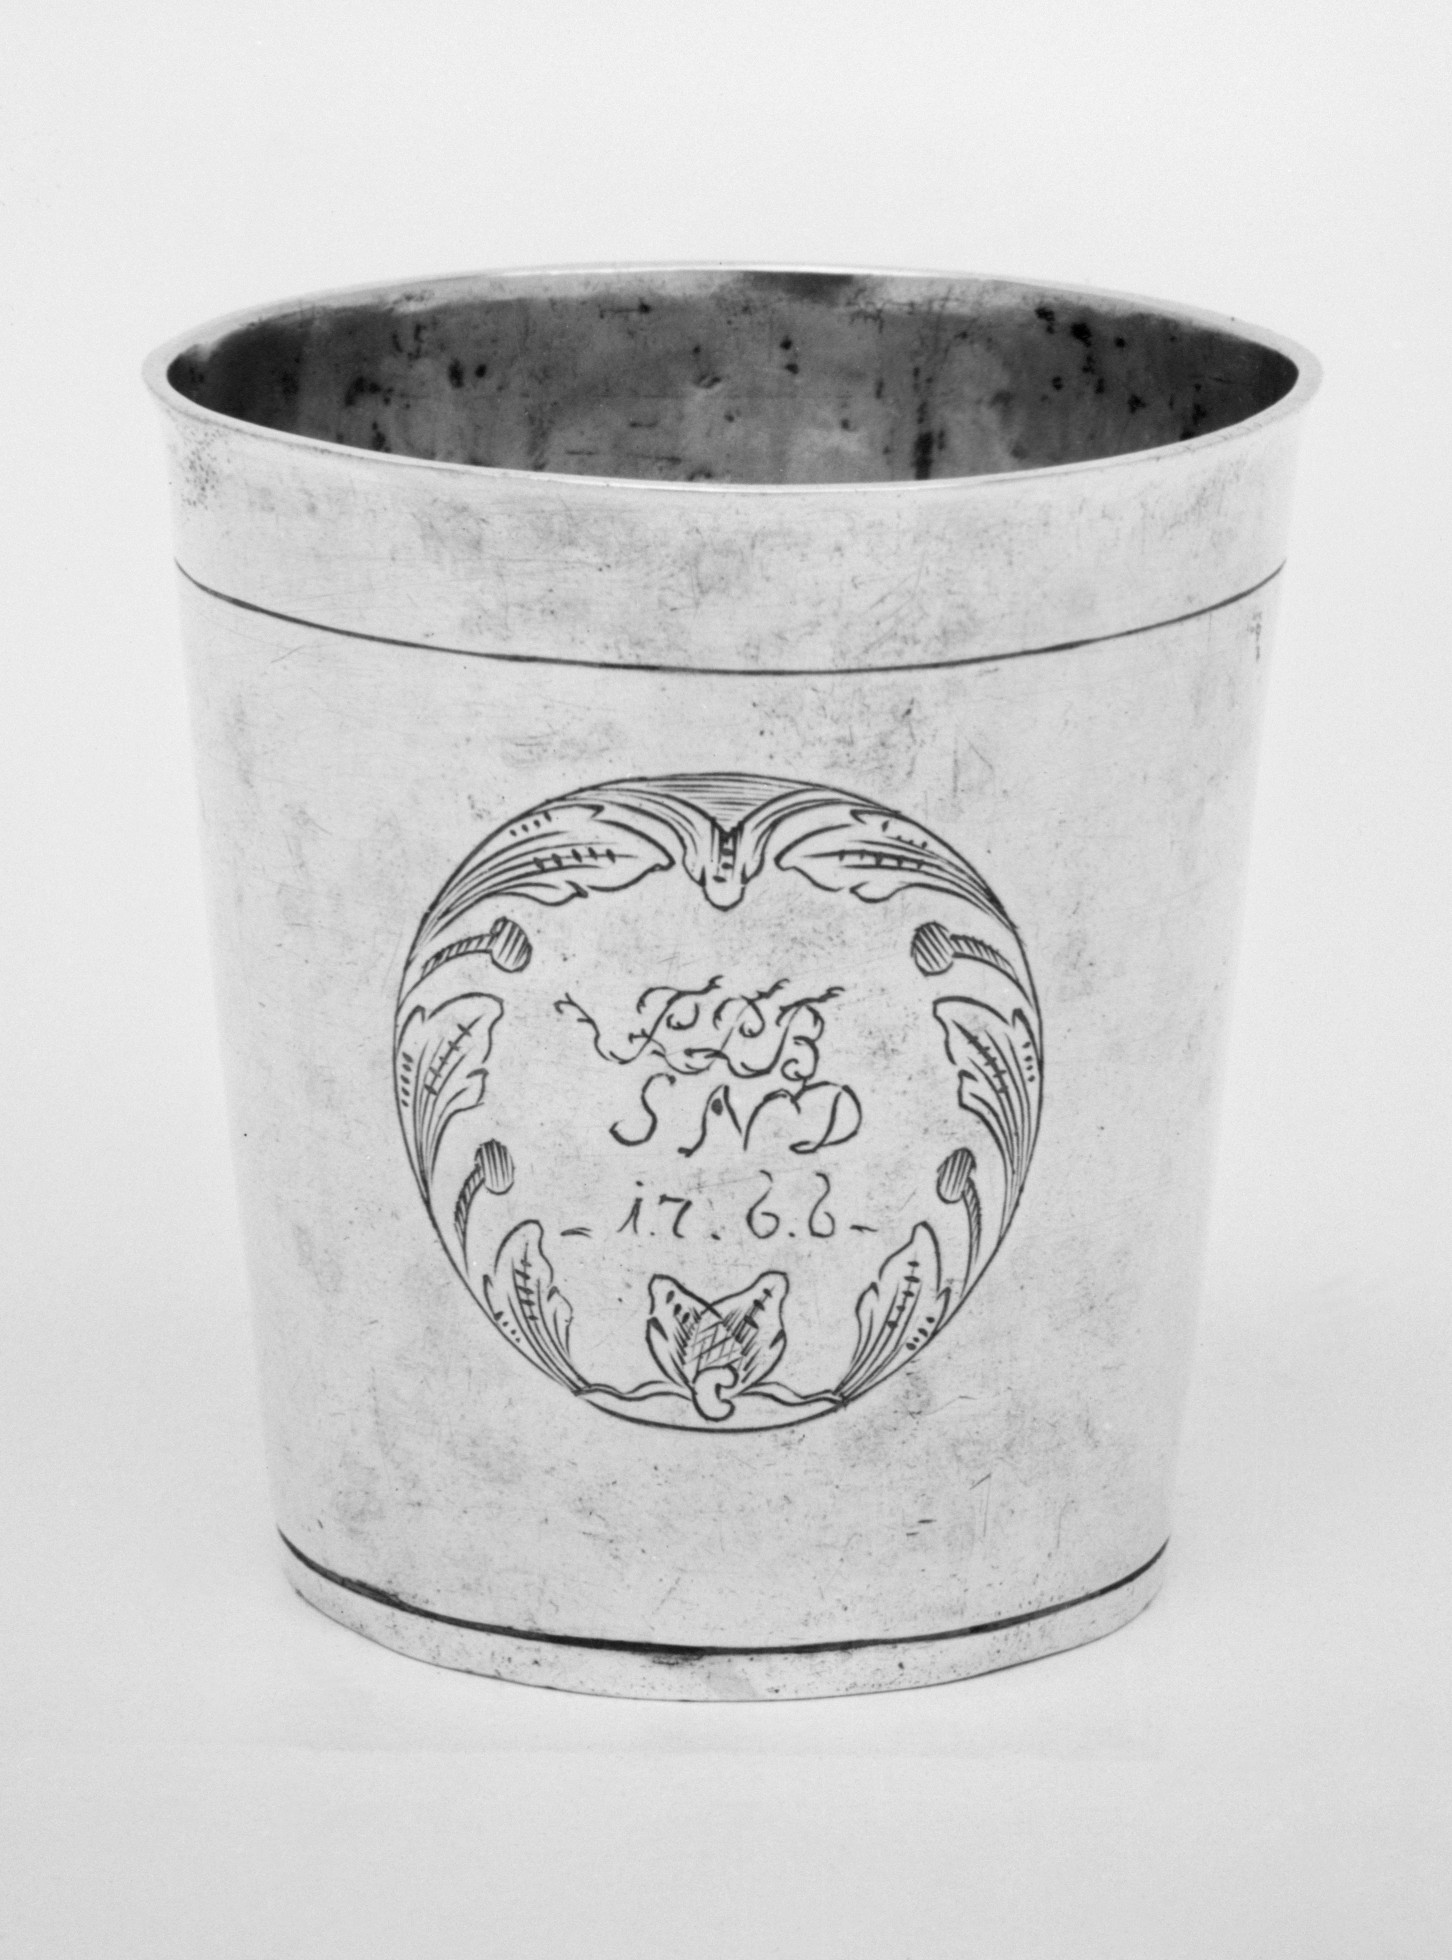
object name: beaker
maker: i. b. (norwegian or danish)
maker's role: maker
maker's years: 1700-1799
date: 1766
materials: silver